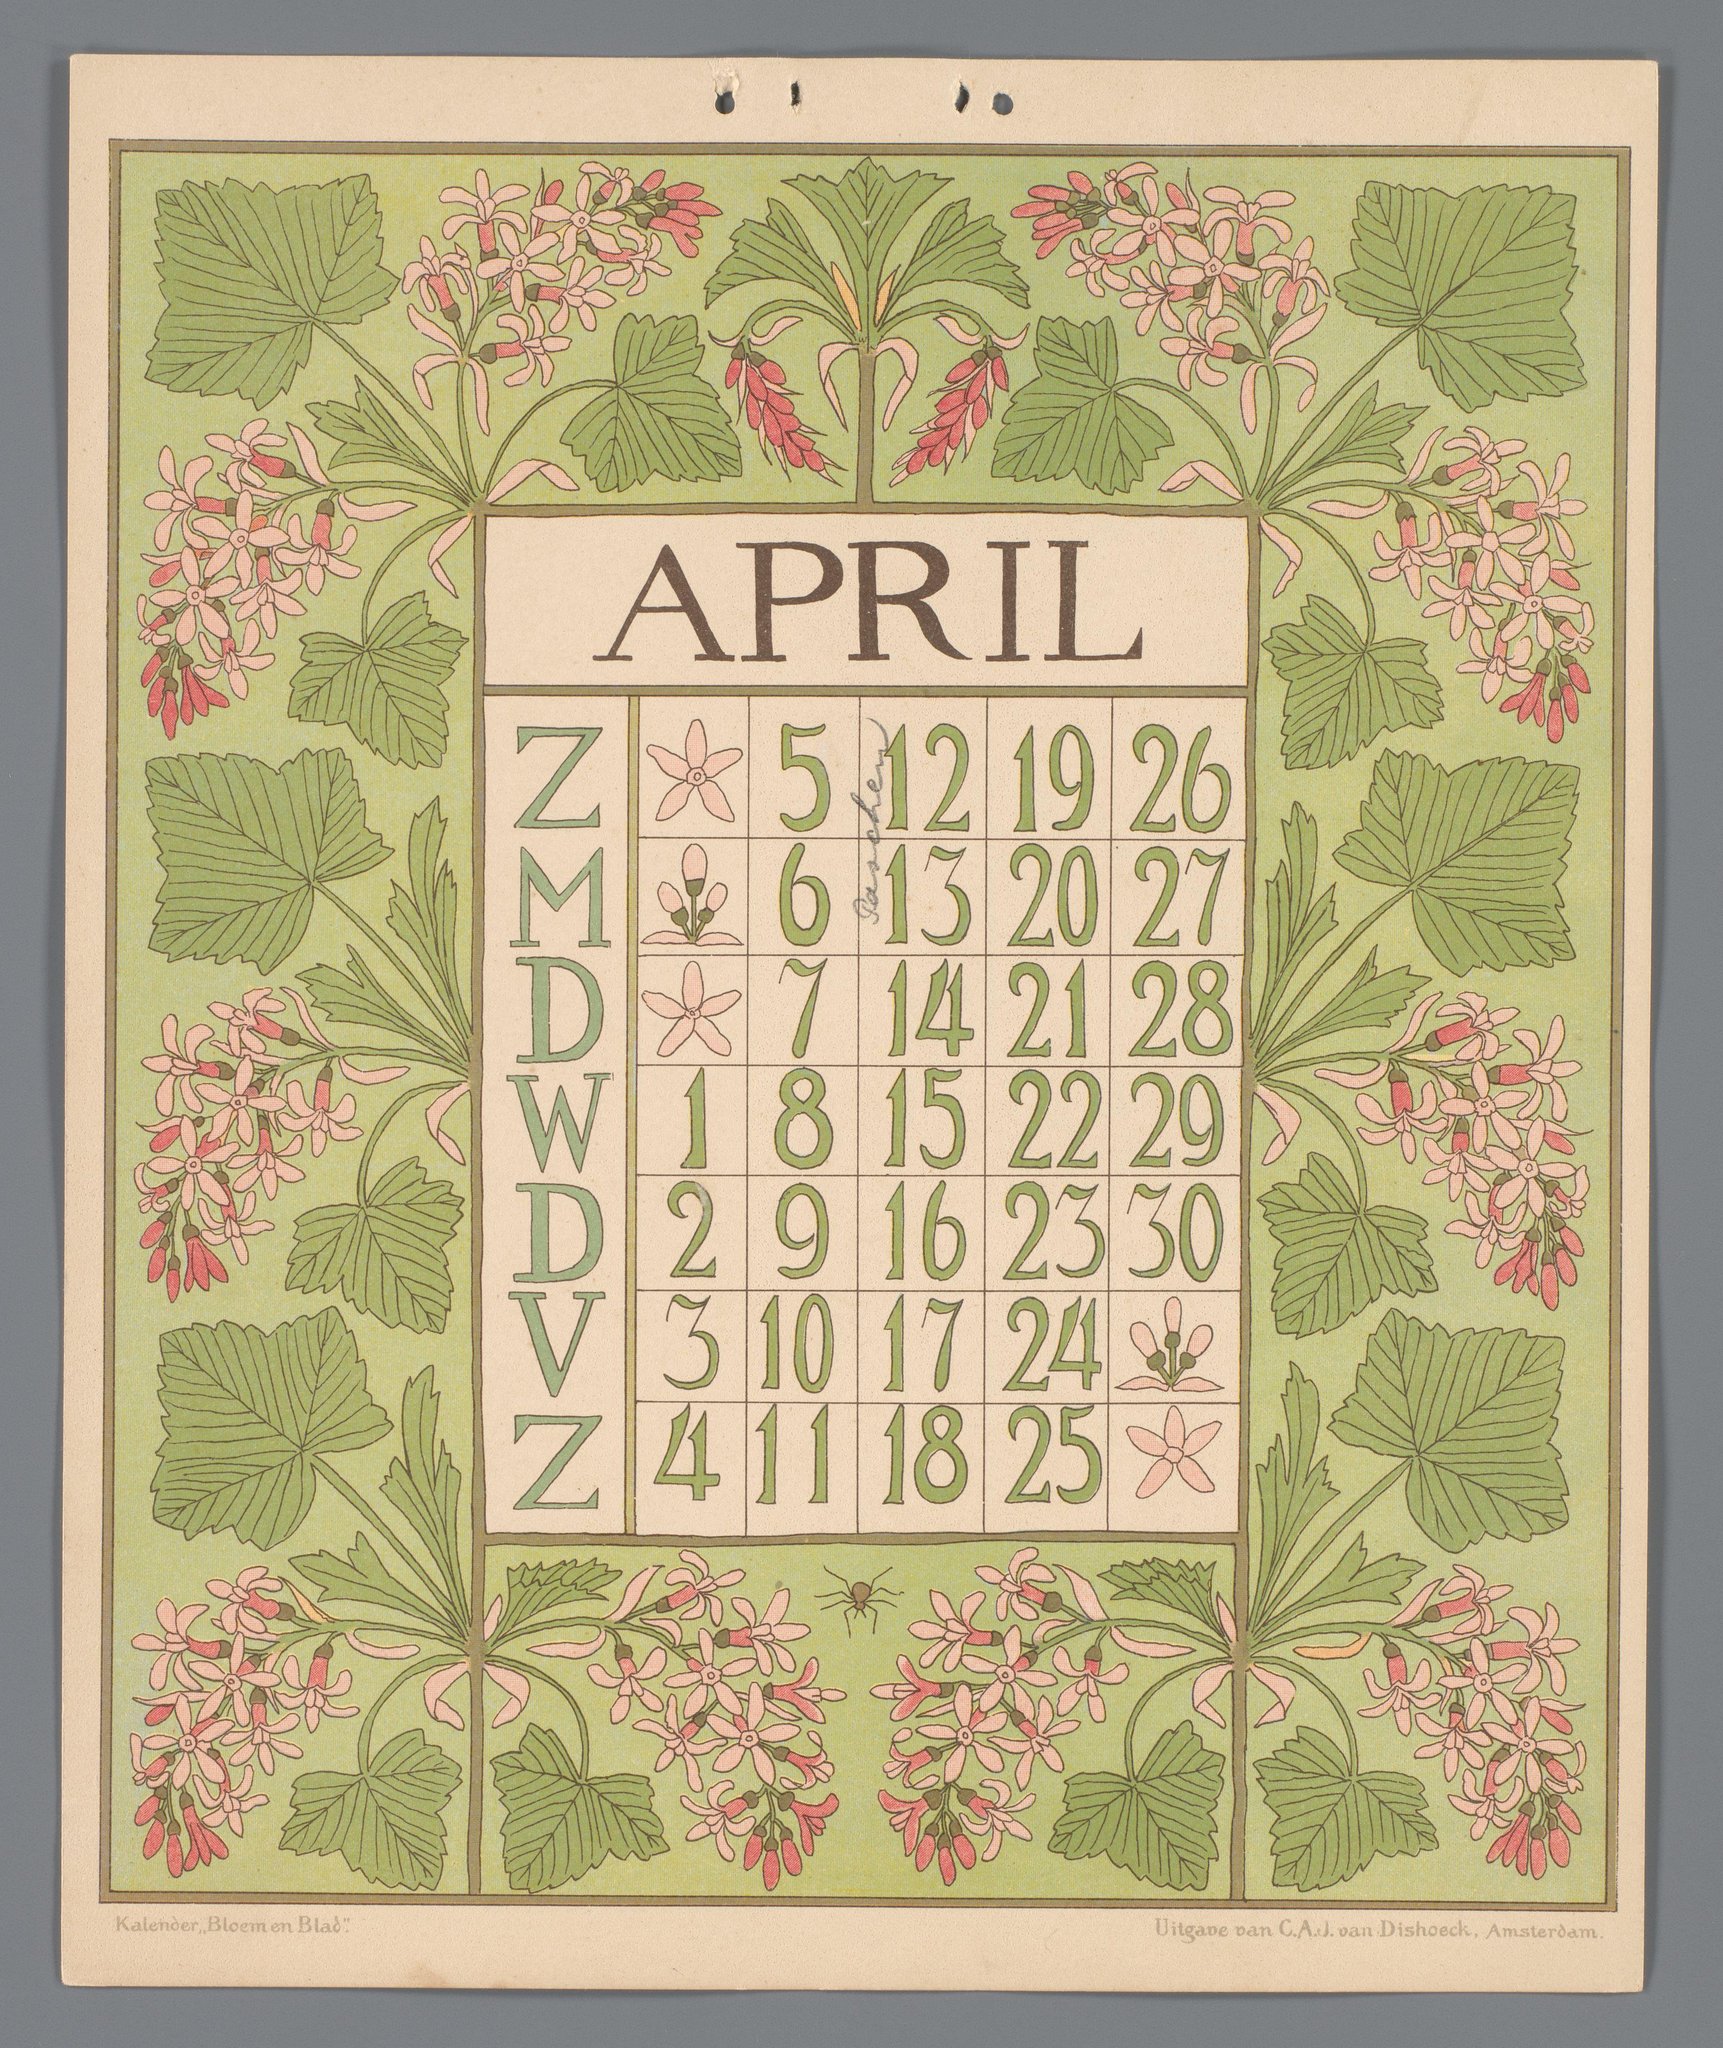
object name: print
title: Kalenderblad voor april van de kalender 'Bloem en blad'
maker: c.a.j. van dishoeck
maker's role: publisher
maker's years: 1863-1931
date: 1900-1910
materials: cordage, paper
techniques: lithograph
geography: amsterdam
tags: flowers, ornaments ~ art, calendar, almanac